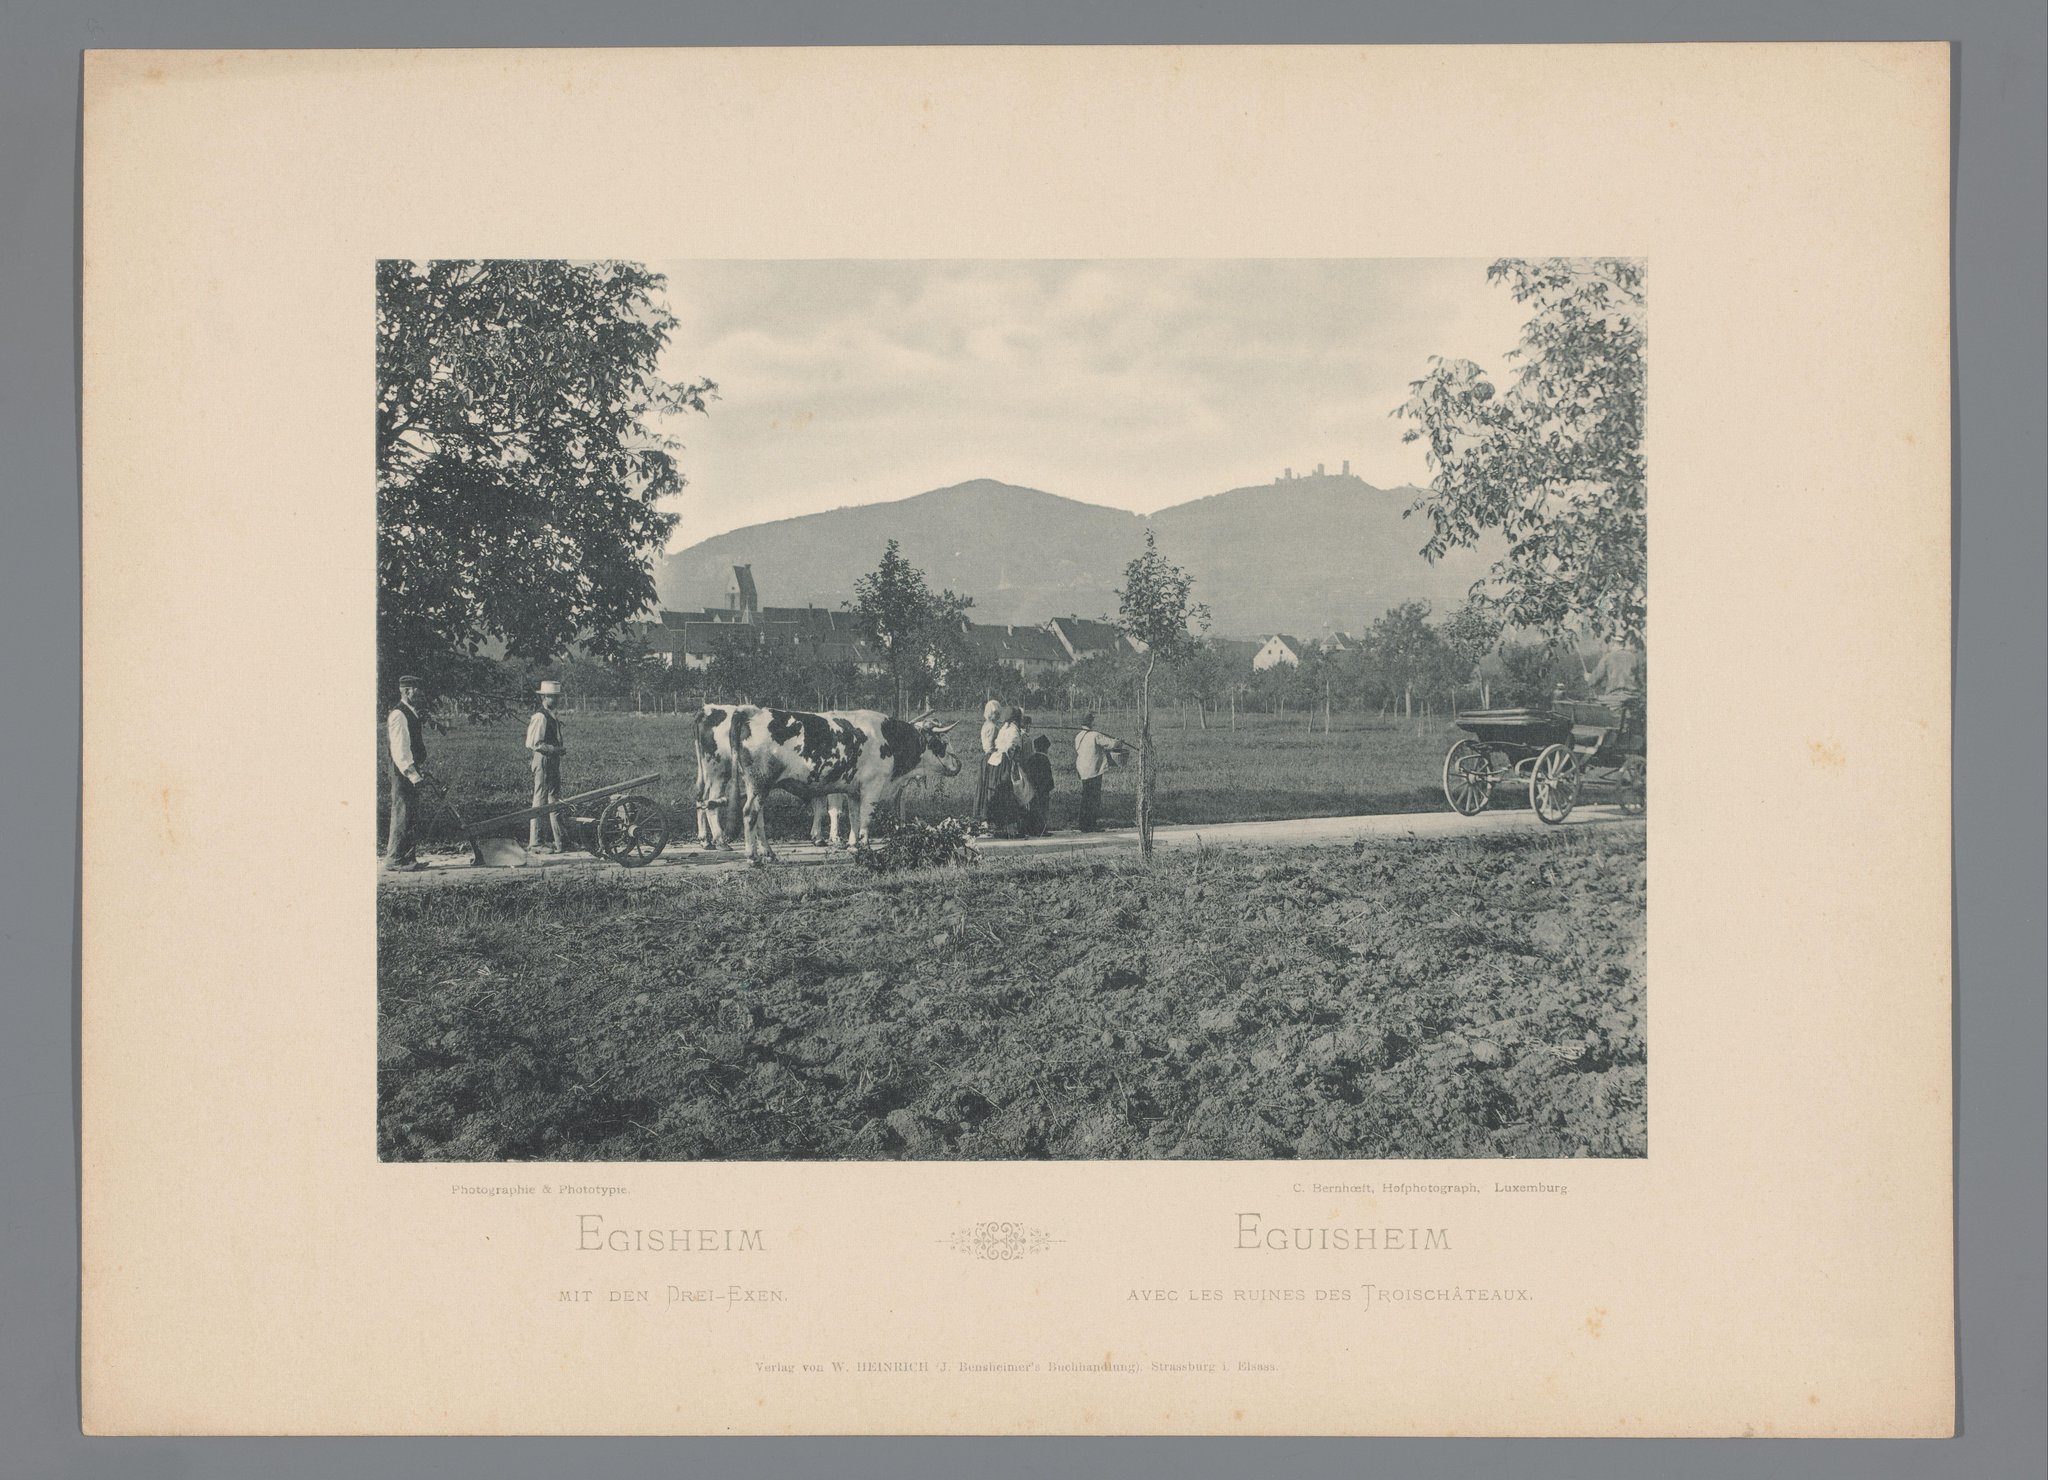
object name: photomechanical print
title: Egisheim, Eguisheim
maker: charles bernhoeft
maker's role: publisher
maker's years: 1859-1933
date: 1889-1894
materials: paper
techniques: photograph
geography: eguisheim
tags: castle, bovine cattle, village street (+ city(-scape) with figures, staffage)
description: Deze prent maakt deel uit van een omslag met 100 prenten.